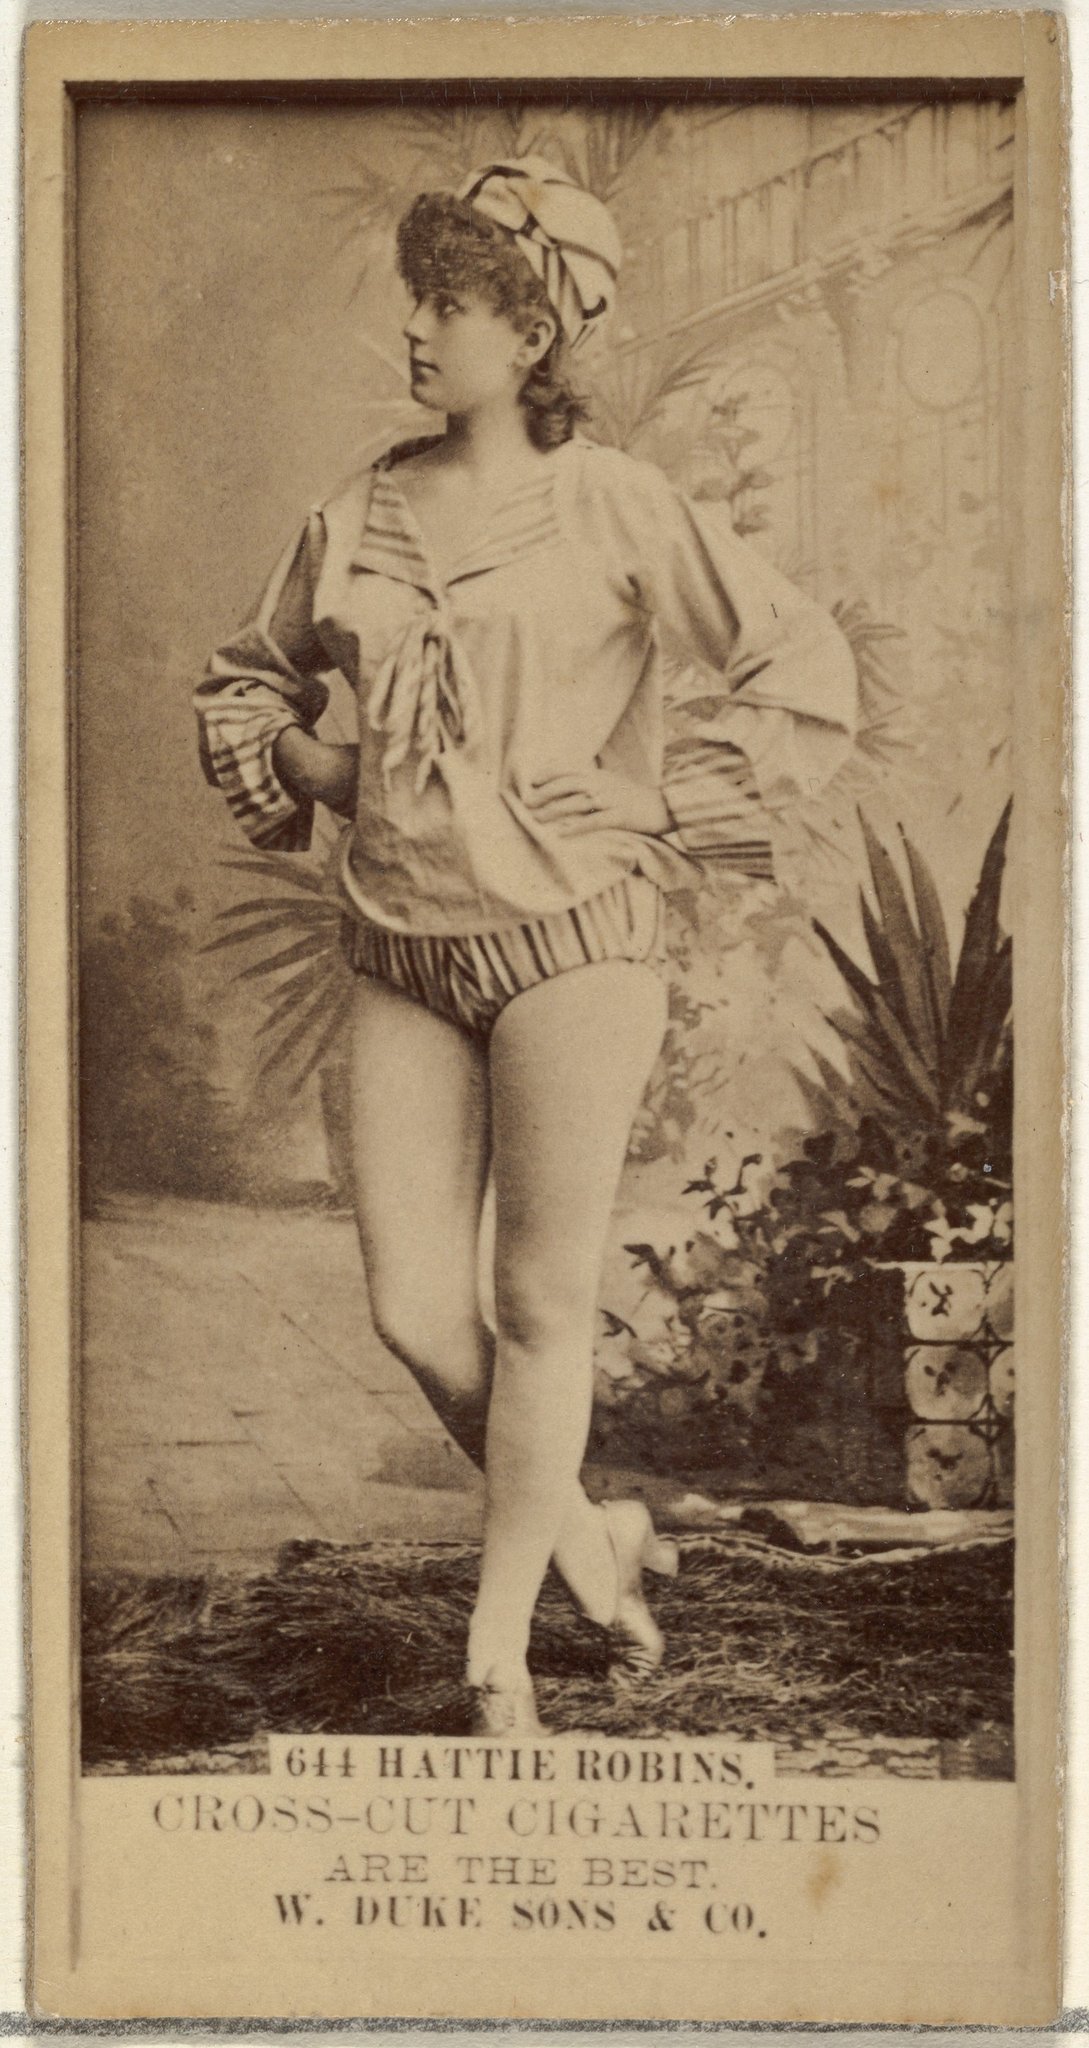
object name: photograph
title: Card Number 644, Hattie Robins, from the Actors and Actresses series (N145-3) issued by Duke Sons & Co. to promote Cross Cut Cigarettes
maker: w. duke, sons & co.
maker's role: publisher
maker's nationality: american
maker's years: 1870-1920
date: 1880-1889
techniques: albumen silver print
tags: women,actresses